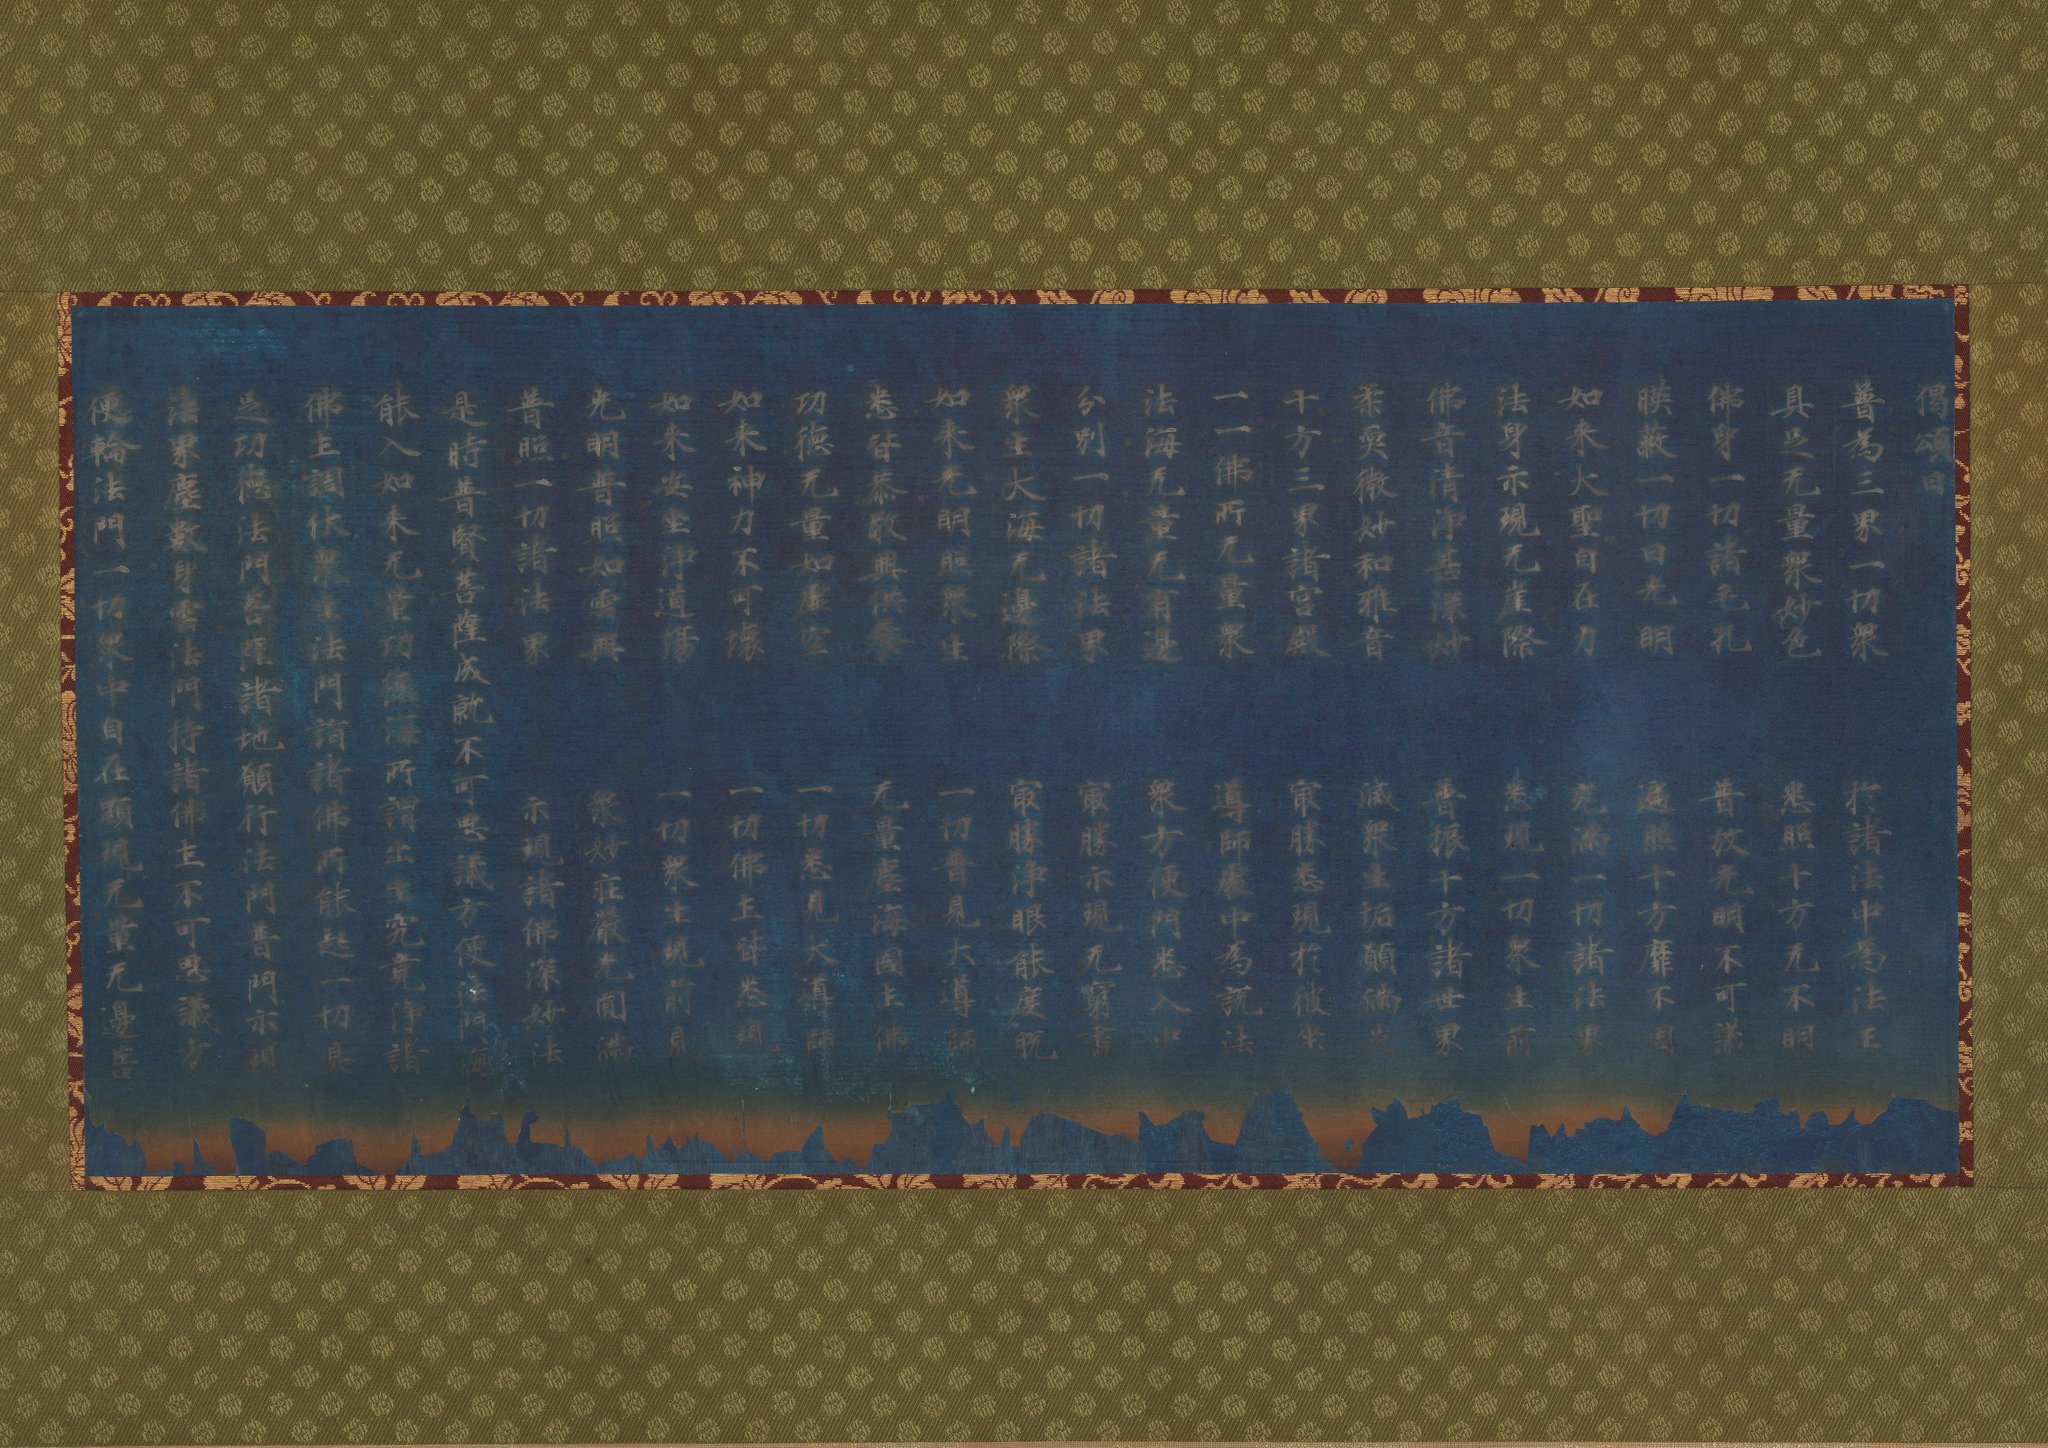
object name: hanging scroll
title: Nigatsudō Burned Sutra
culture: japanese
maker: unidentified artist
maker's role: artist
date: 744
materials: ink, paper, silver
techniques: dyeing